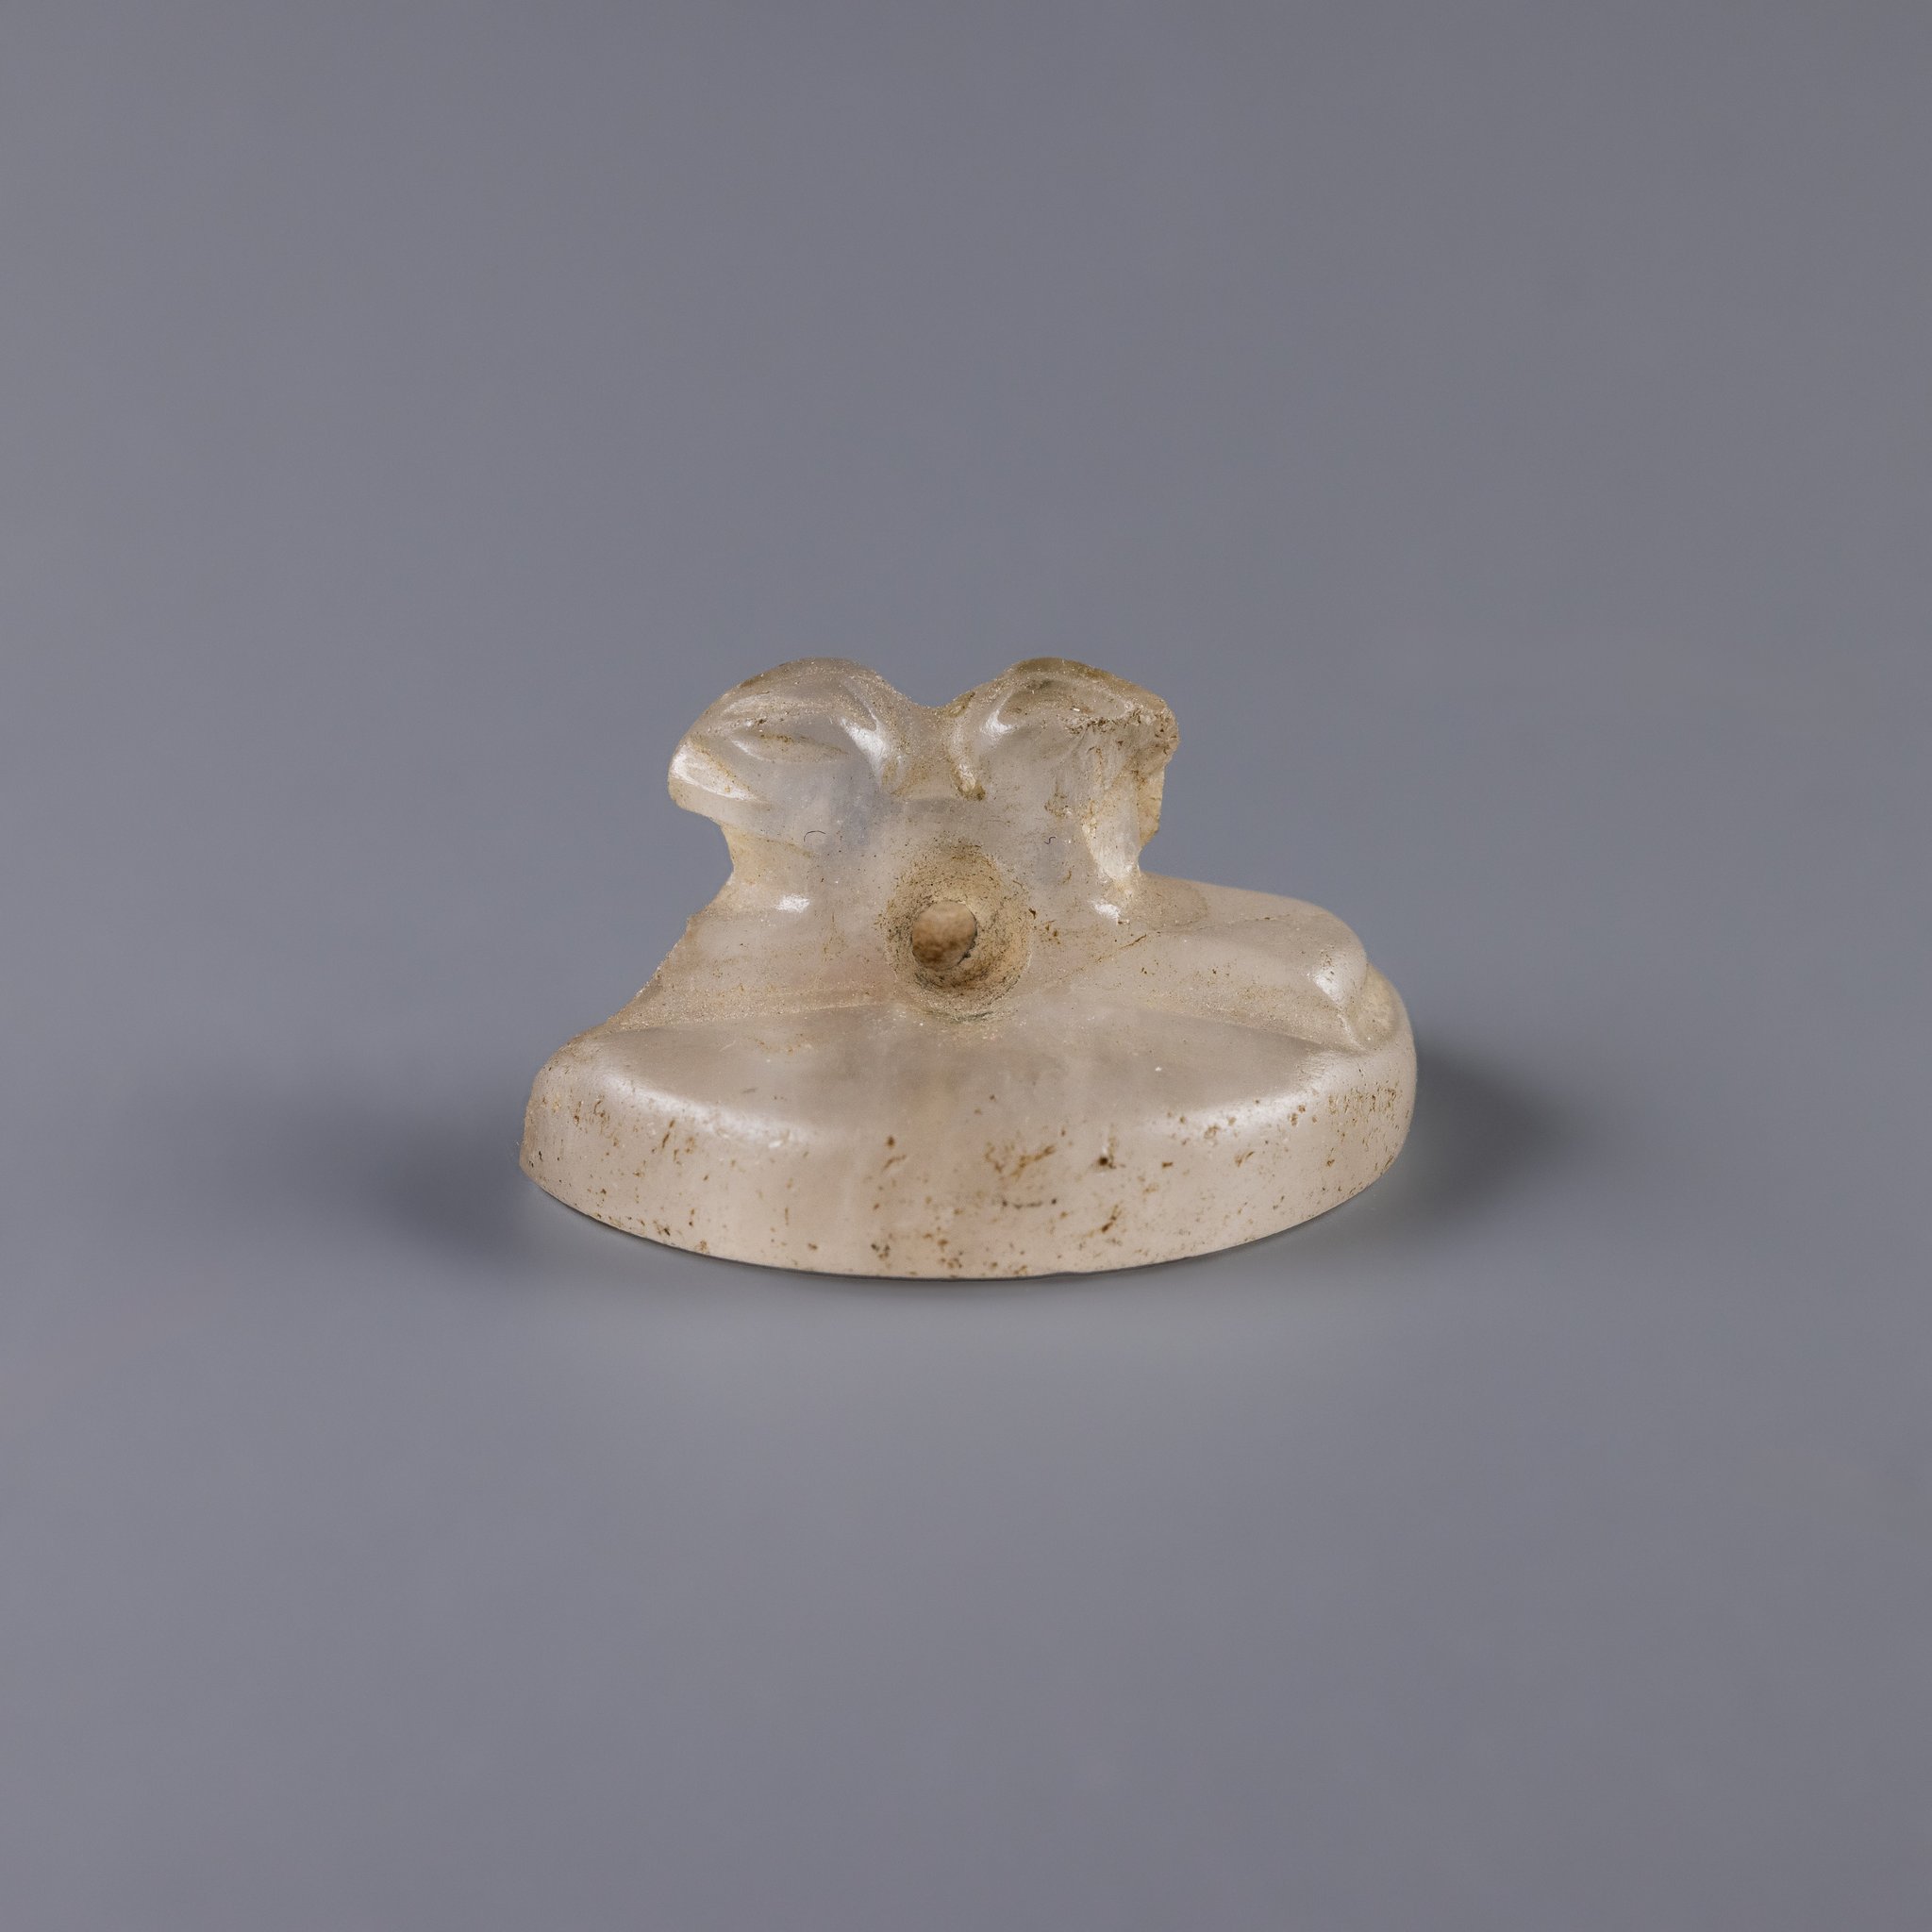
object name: design amulet, falcon head, hare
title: Design Amulet, a Double-Falconhead Shank Pierced Transversally on the Back, Device showing Two Hares Head-to-tail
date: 2100-2080 BCE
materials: quartz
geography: egypt